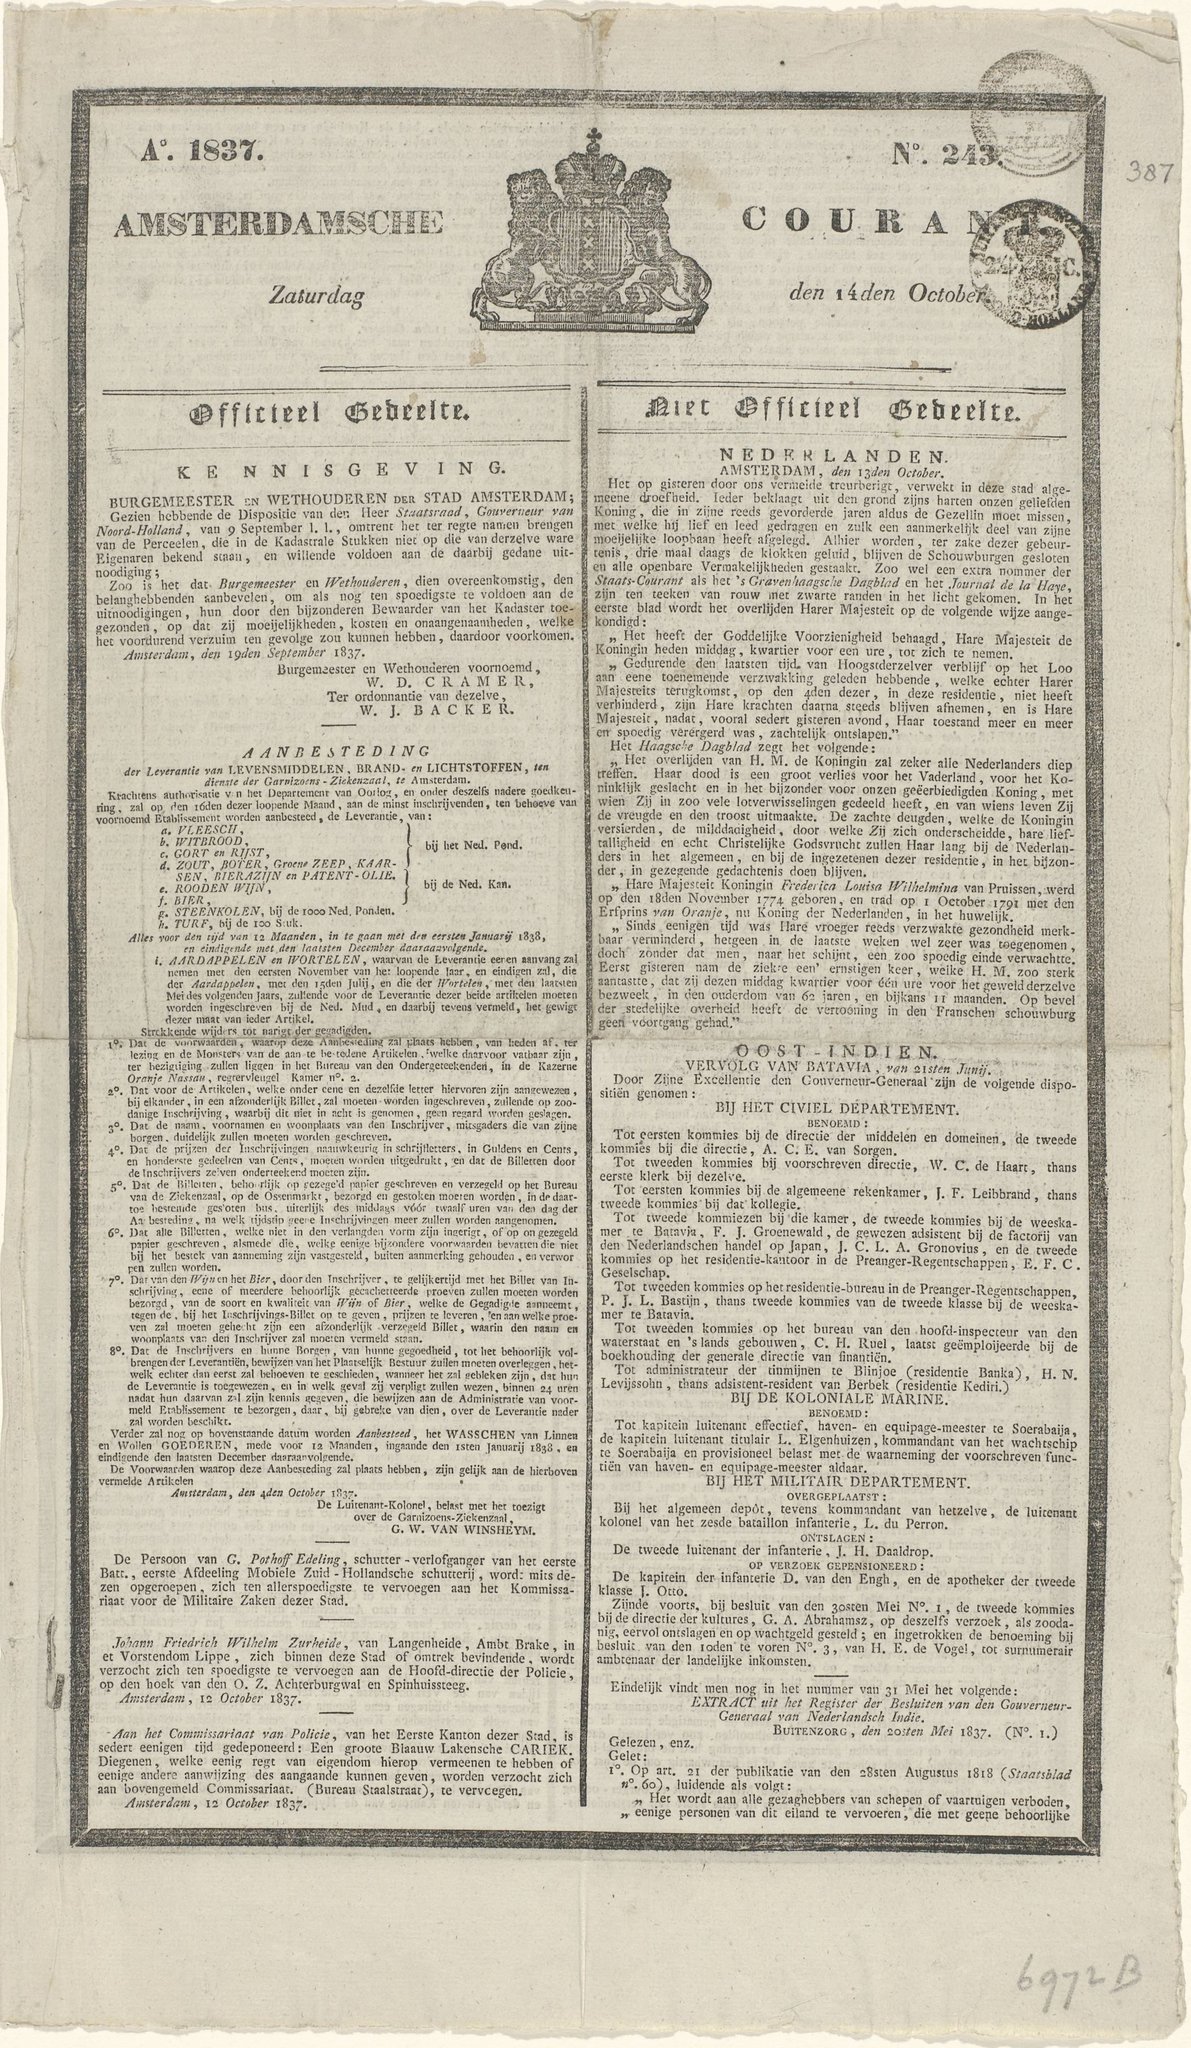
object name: newspaper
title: Amsterdamsche Courant. Zaturdag den 14den October. Ao. 1837. No. 243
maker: jacobus van bonga jr.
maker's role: printer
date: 1837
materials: paper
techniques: letterpress printing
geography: amsterdam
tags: berlin, the hague, wilhelmina frederica louisa (koningin der nederlanden)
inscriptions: collector's mark: Lugt 2228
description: Exemplaar van de Amsterdamsche Courant van 14 oktober 1837 met nieuws over de dood van koningin Wilhelmina van Pruisen op 12 oktober 1837. Dubbelgevouwen blad bedrukt op alle zijden.